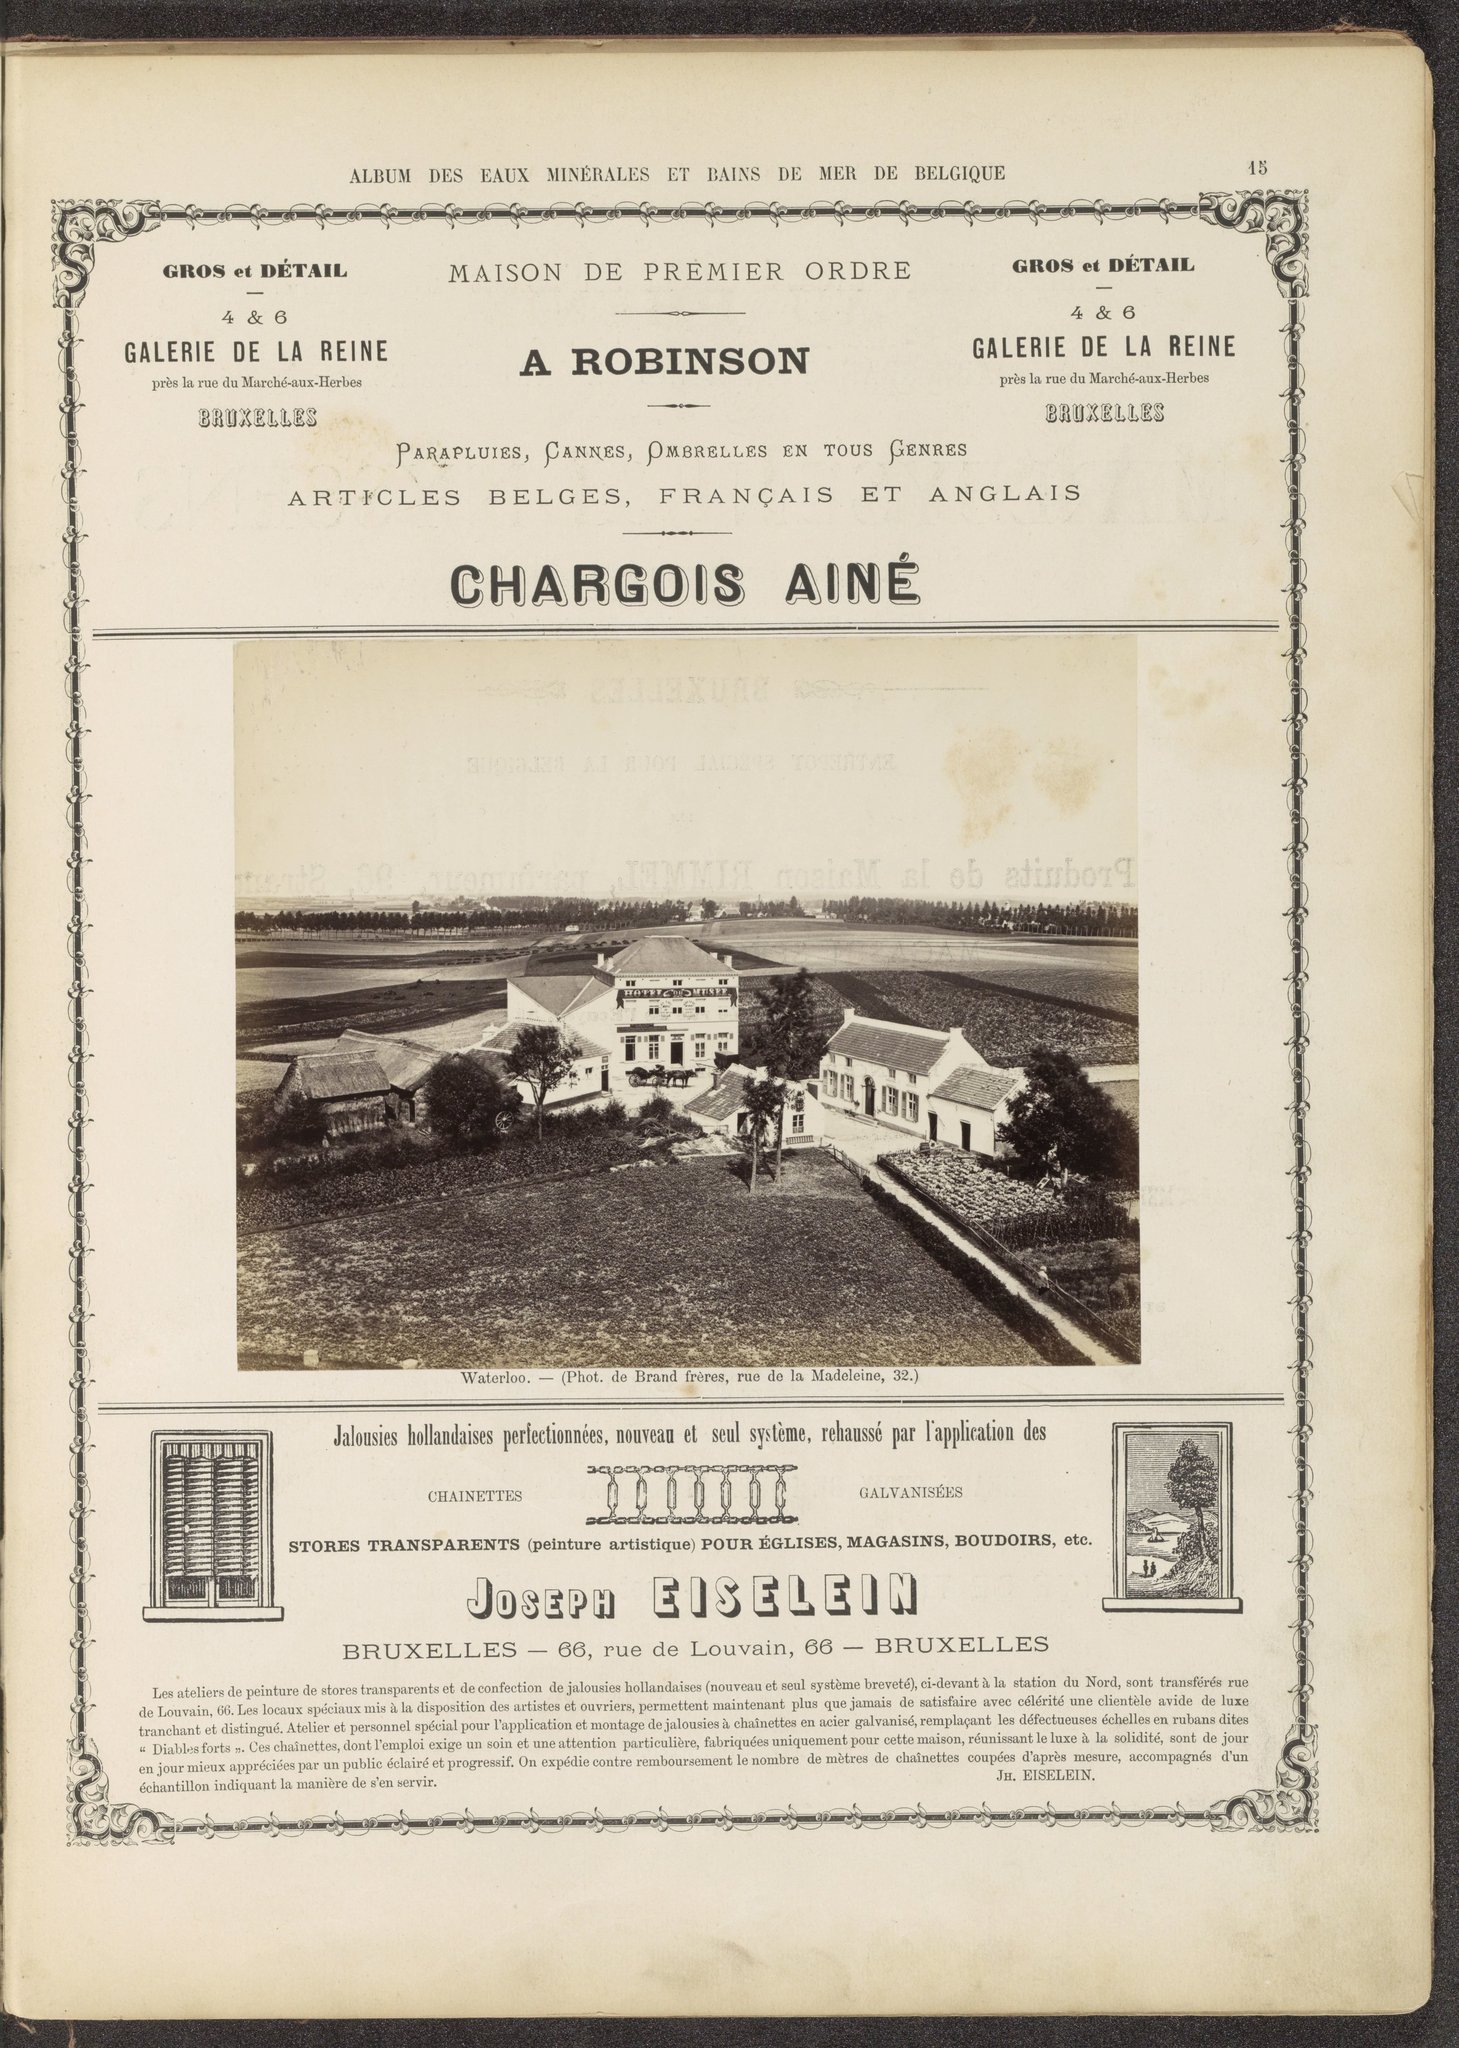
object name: page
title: Gezicht op het Hôtel du Musée te Waterloo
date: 1862-1872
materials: photographic support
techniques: albumen print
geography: waterloo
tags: rural housing, e.g. country-house, villa, cottage, façade (of house or building)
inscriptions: name: ‘(Phot. de Brand frères, rue de la Madeleine, 32.)’